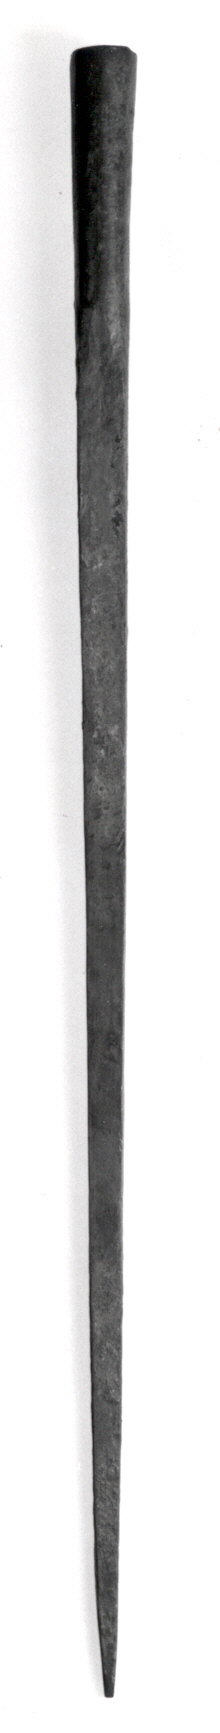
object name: spike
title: Copper Spike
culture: moche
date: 1-500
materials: copper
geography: peru